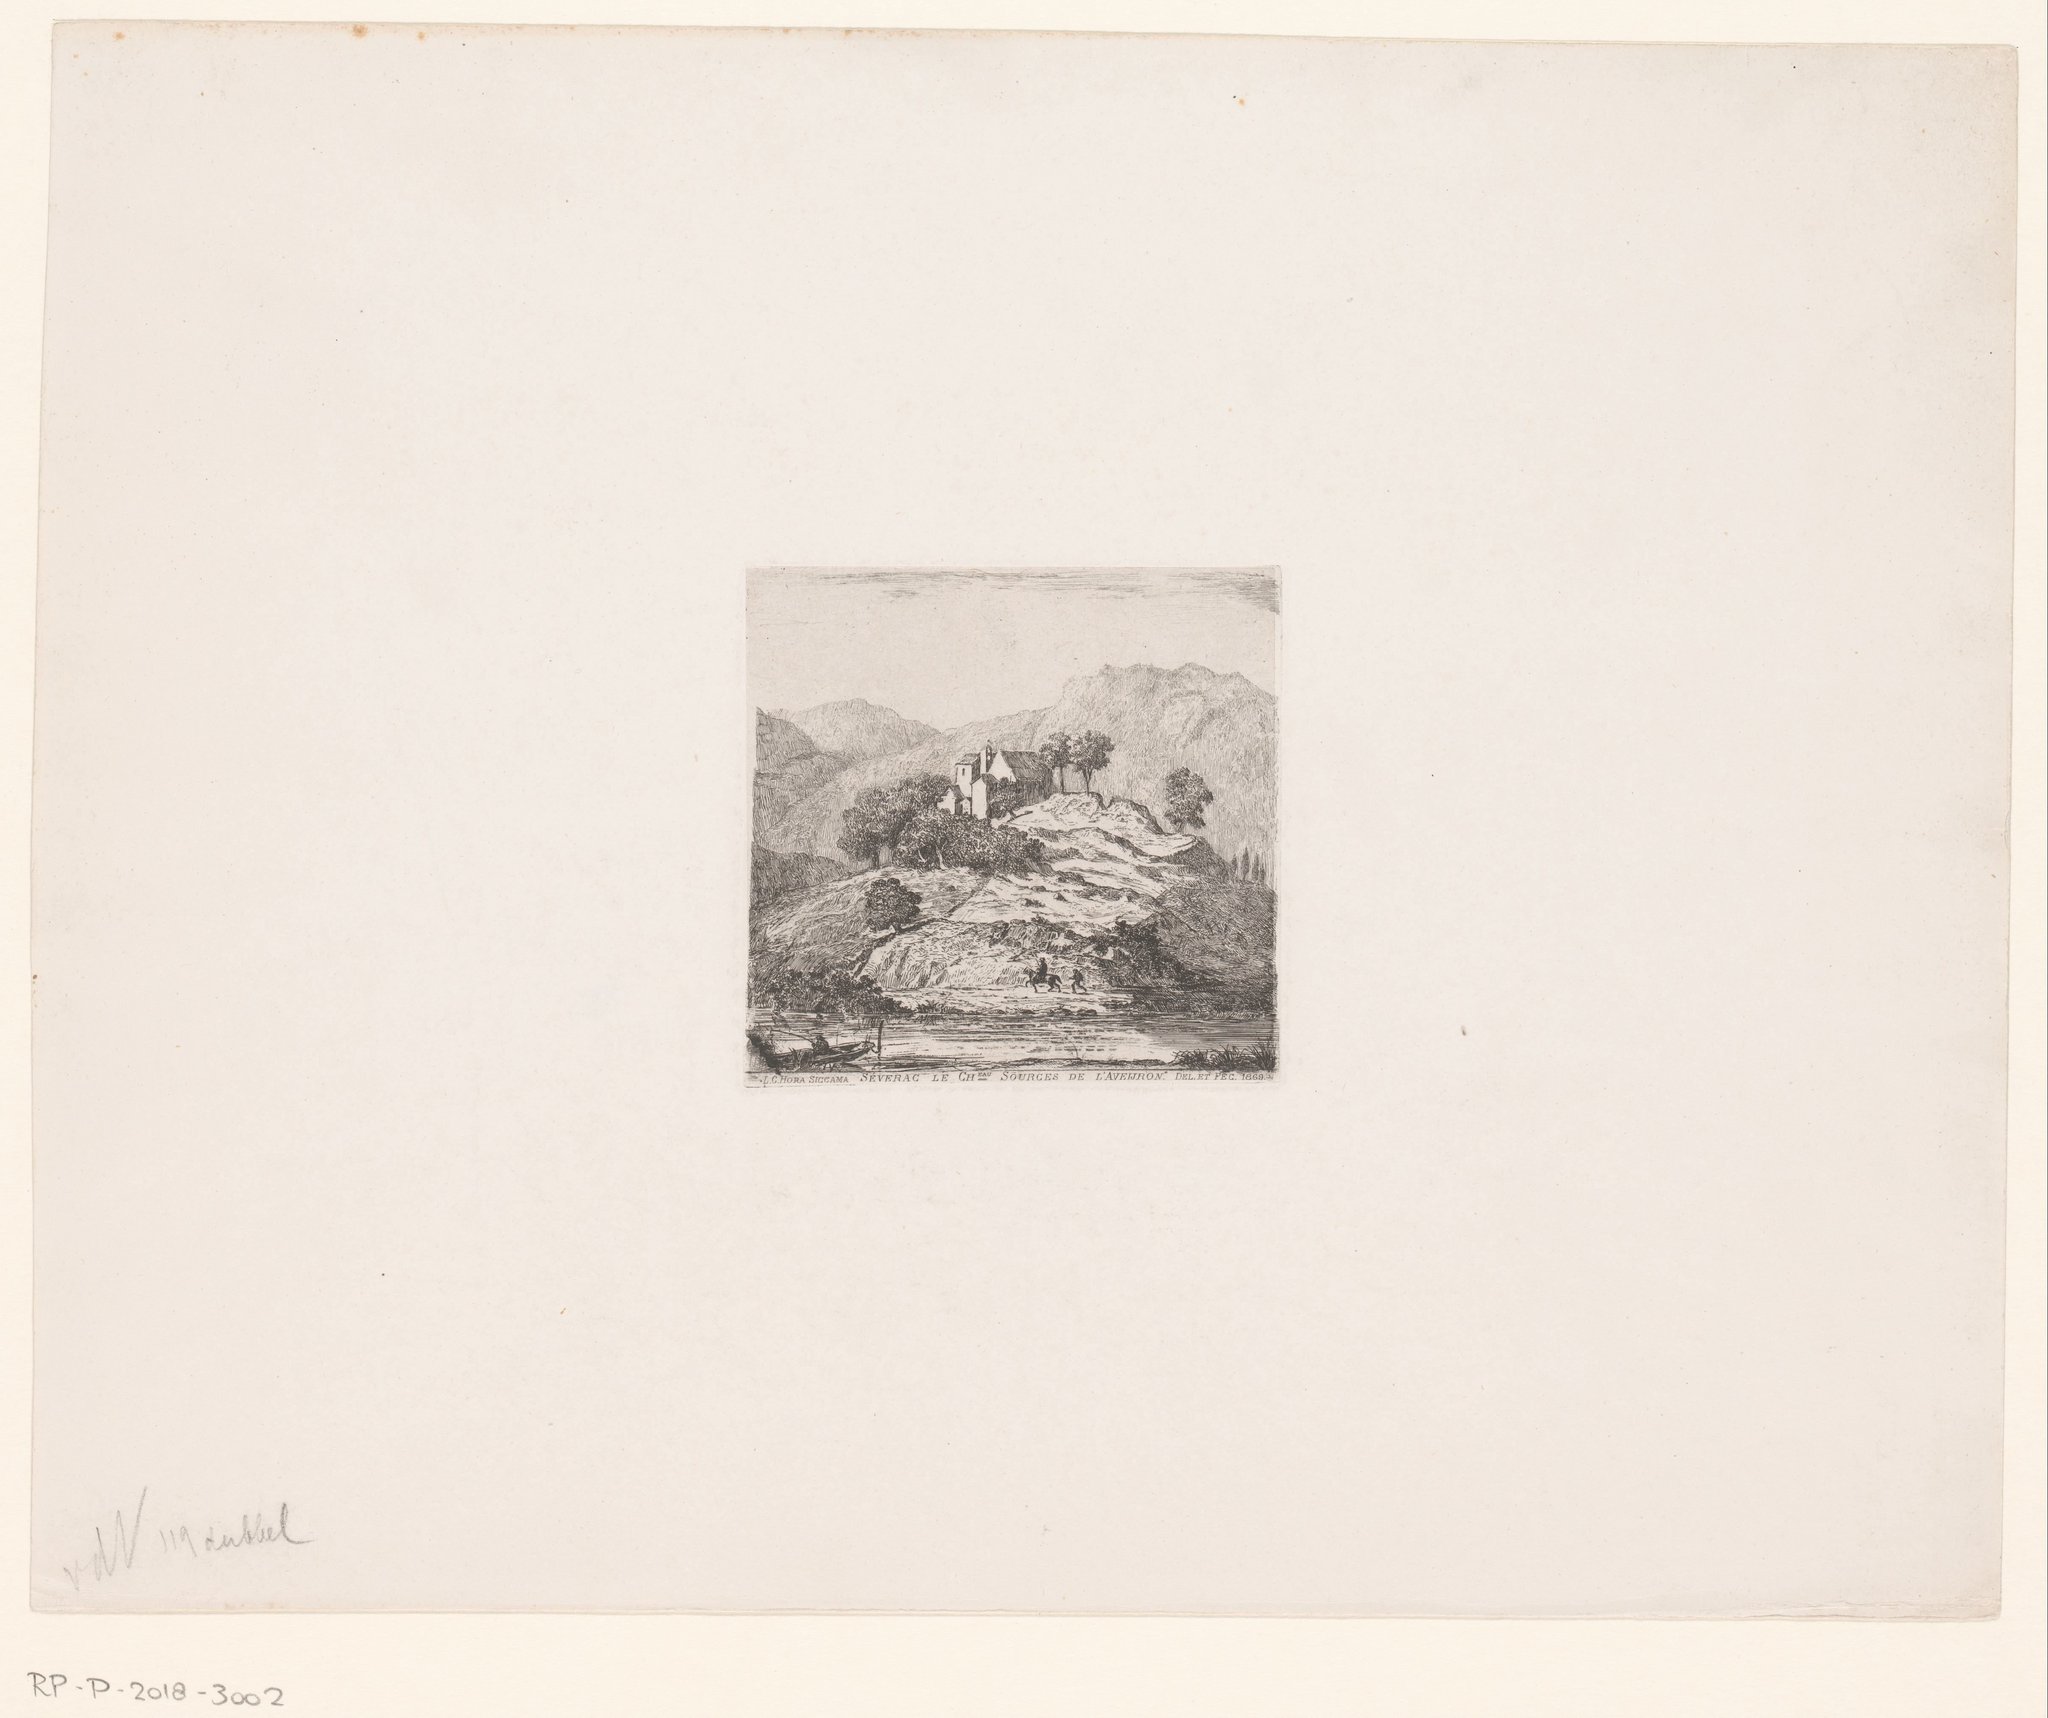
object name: print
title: Séverac le Cheau Sources de l'Aveijron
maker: louis charles hora siccama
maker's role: draughtsman, print maker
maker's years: 1807-1880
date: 1869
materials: paper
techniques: drypoint, etching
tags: chateau-de-sévérac (aveyron, frankrijk)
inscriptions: collector's mark: Lugt 2228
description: Een man te paard loopt met een andere man langs de oevers van de rivier Aveyron. Op de heuveltop boven hen ligt het kasteel van Sévérac. Linksvoor een visser in een roeiboot.